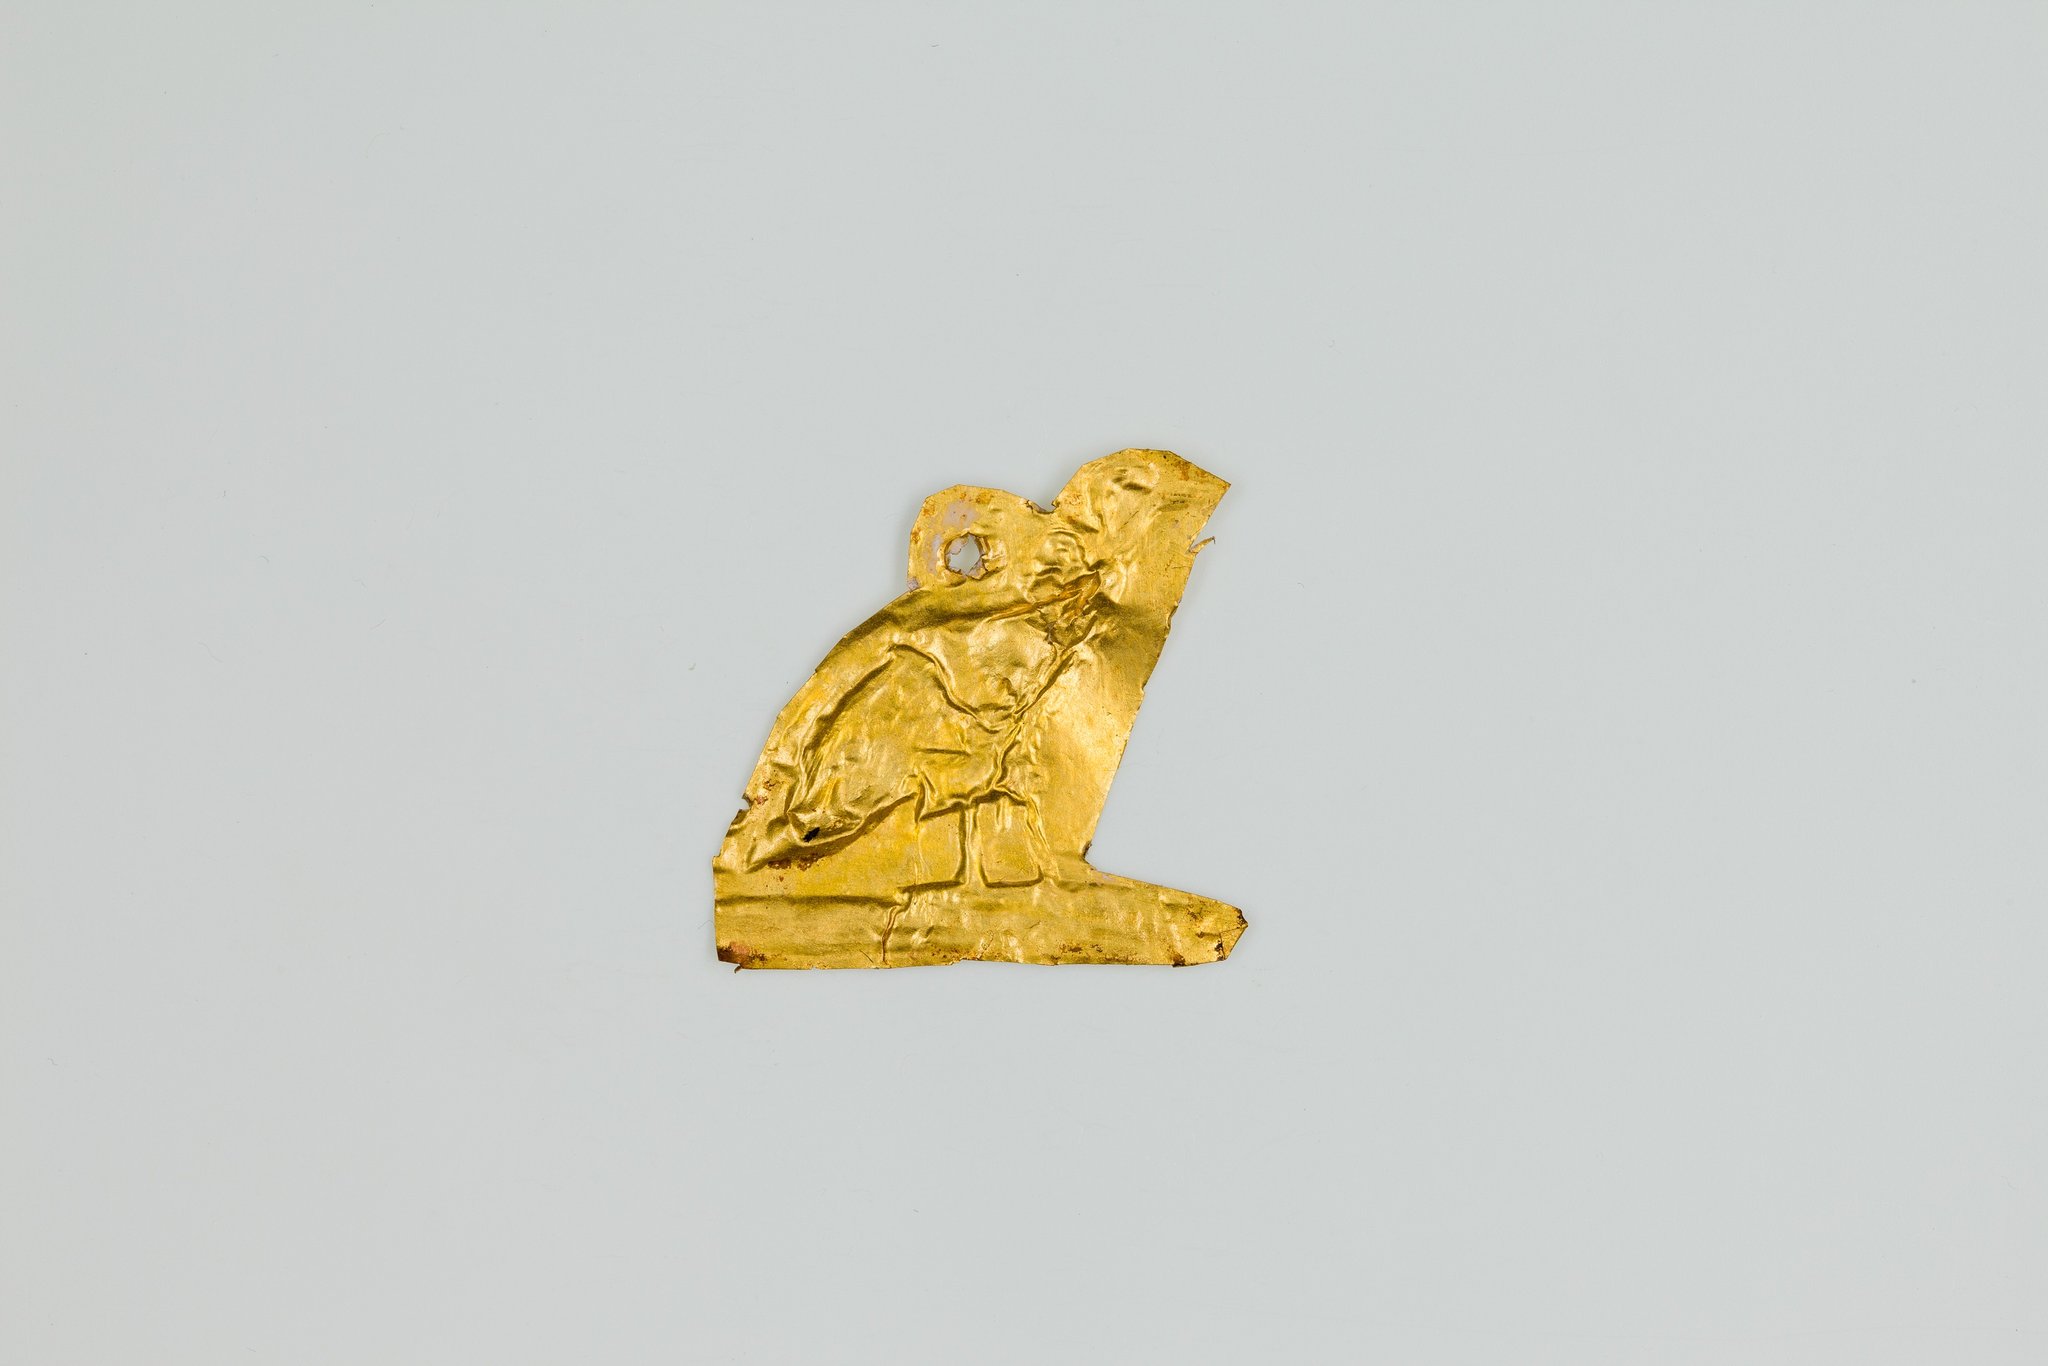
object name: amulet, vulture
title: Vulture amulet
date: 664-380 BCE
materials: gold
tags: birds